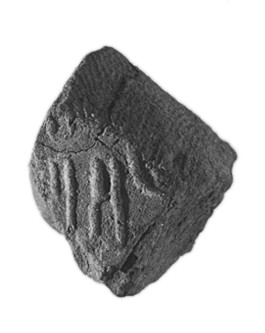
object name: sealing fragment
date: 2030-1640 BCE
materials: clay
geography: egypt